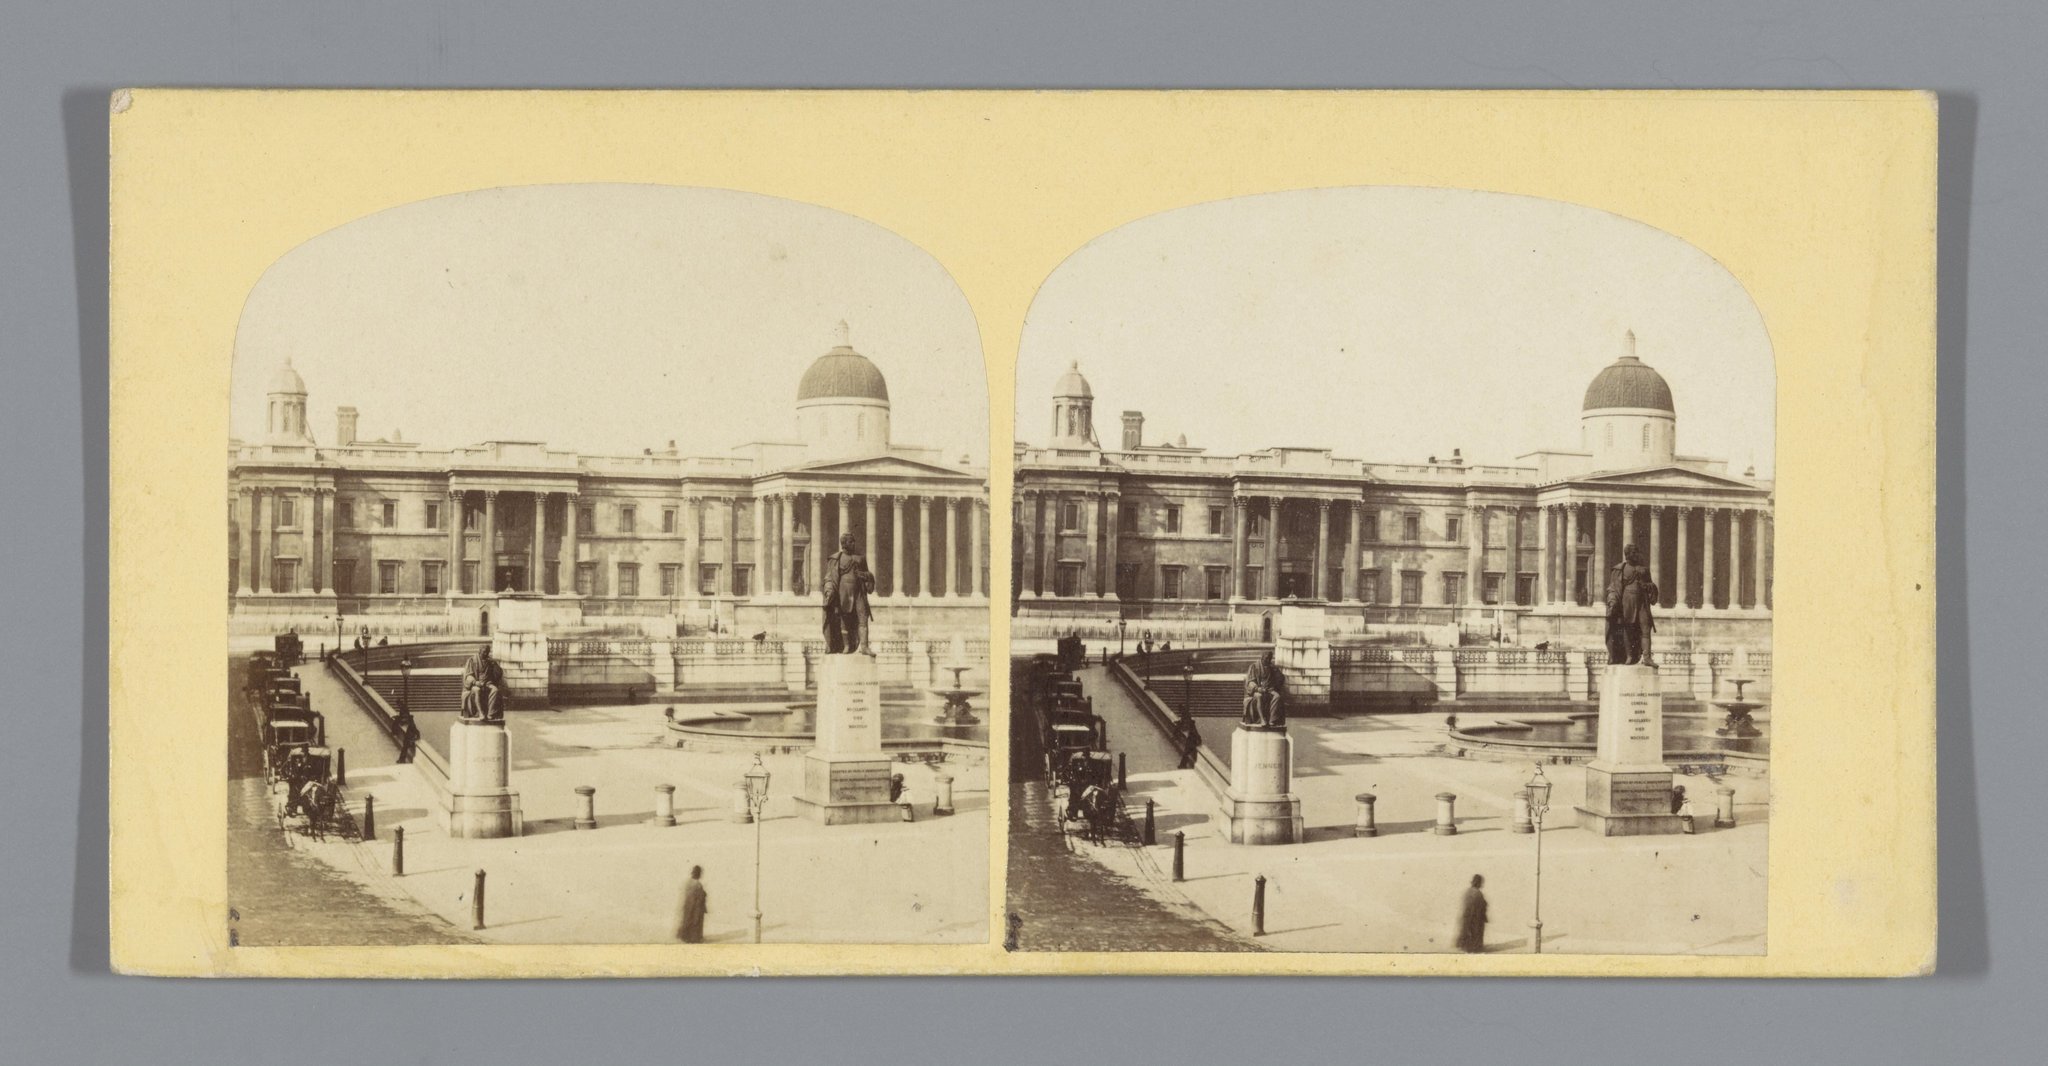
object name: stereograph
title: Trafalgar Square, looking North, showing the National Gallery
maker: Anonymous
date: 1850-1880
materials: cardboard, photographic support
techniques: albumen print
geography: london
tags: square, place, circus, etc., permanent exhibition, museum